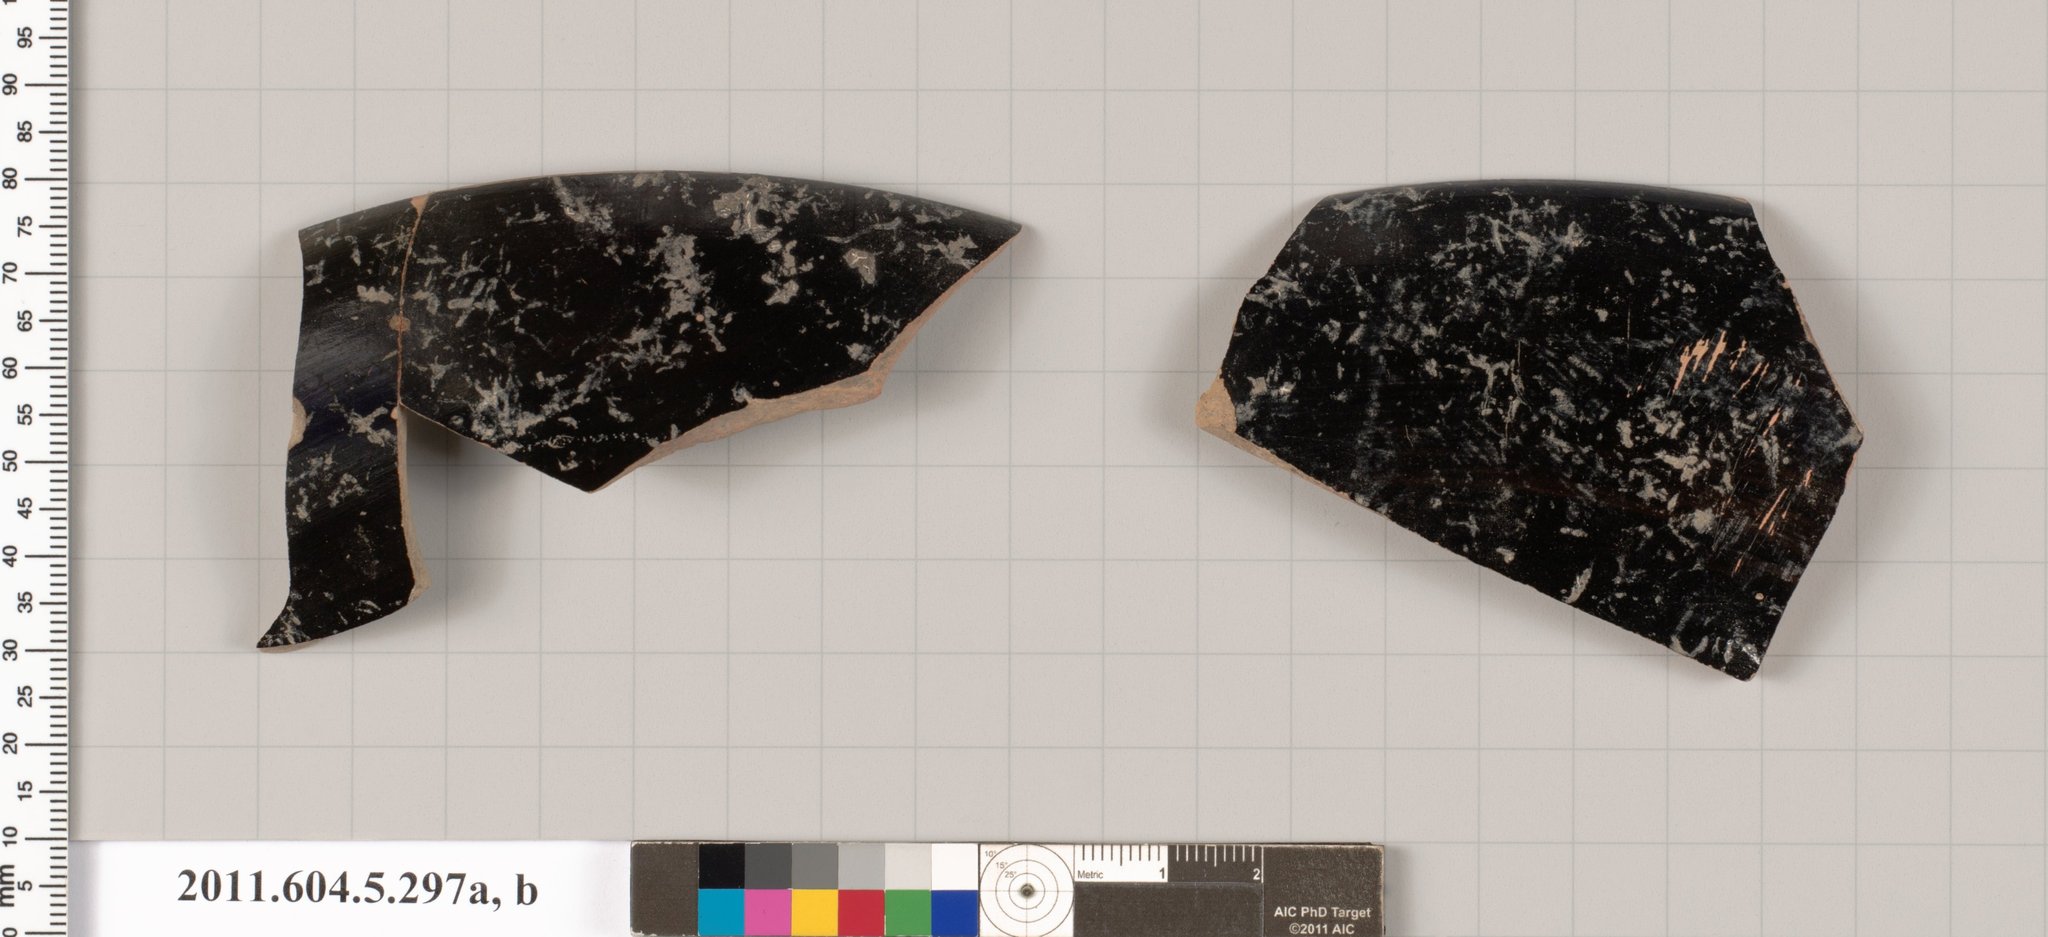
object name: kylix fragment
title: Terracotta rim fragments of a kylix (drinking cup)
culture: greek, attic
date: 600-401 BCE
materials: terracotta